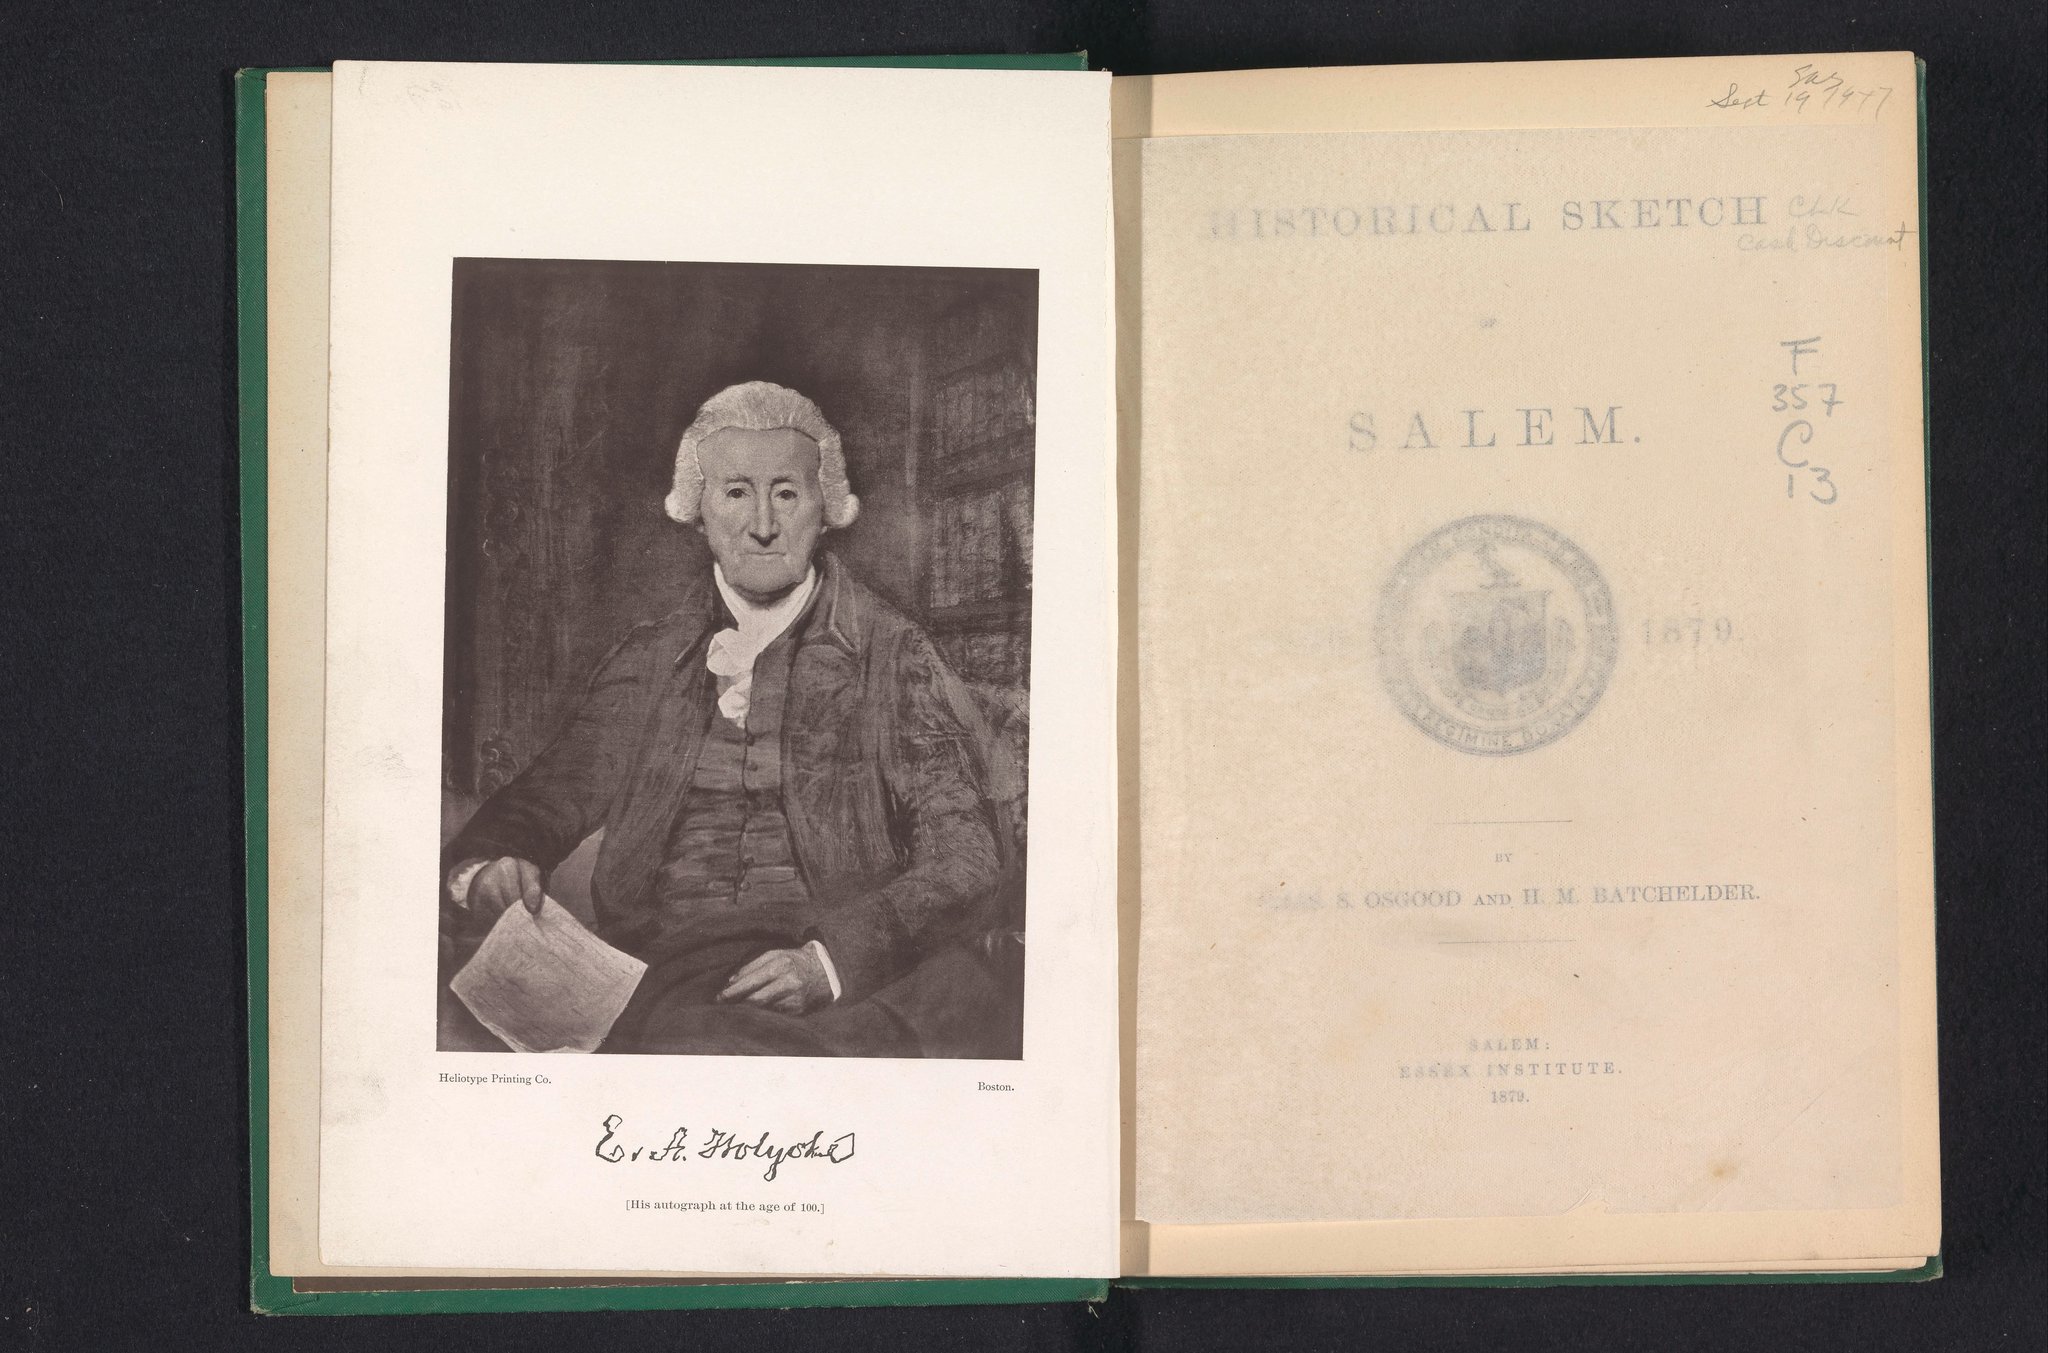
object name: page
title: Fotoreproductie van een portret van Edward Augustus Holyoke door James Frothingham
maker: Anonymous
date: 1869-1879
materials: paper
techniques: photoaquatint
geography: boston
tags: physician, doctor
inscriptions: inscription: ‘(His autograph at the age of 100.)’